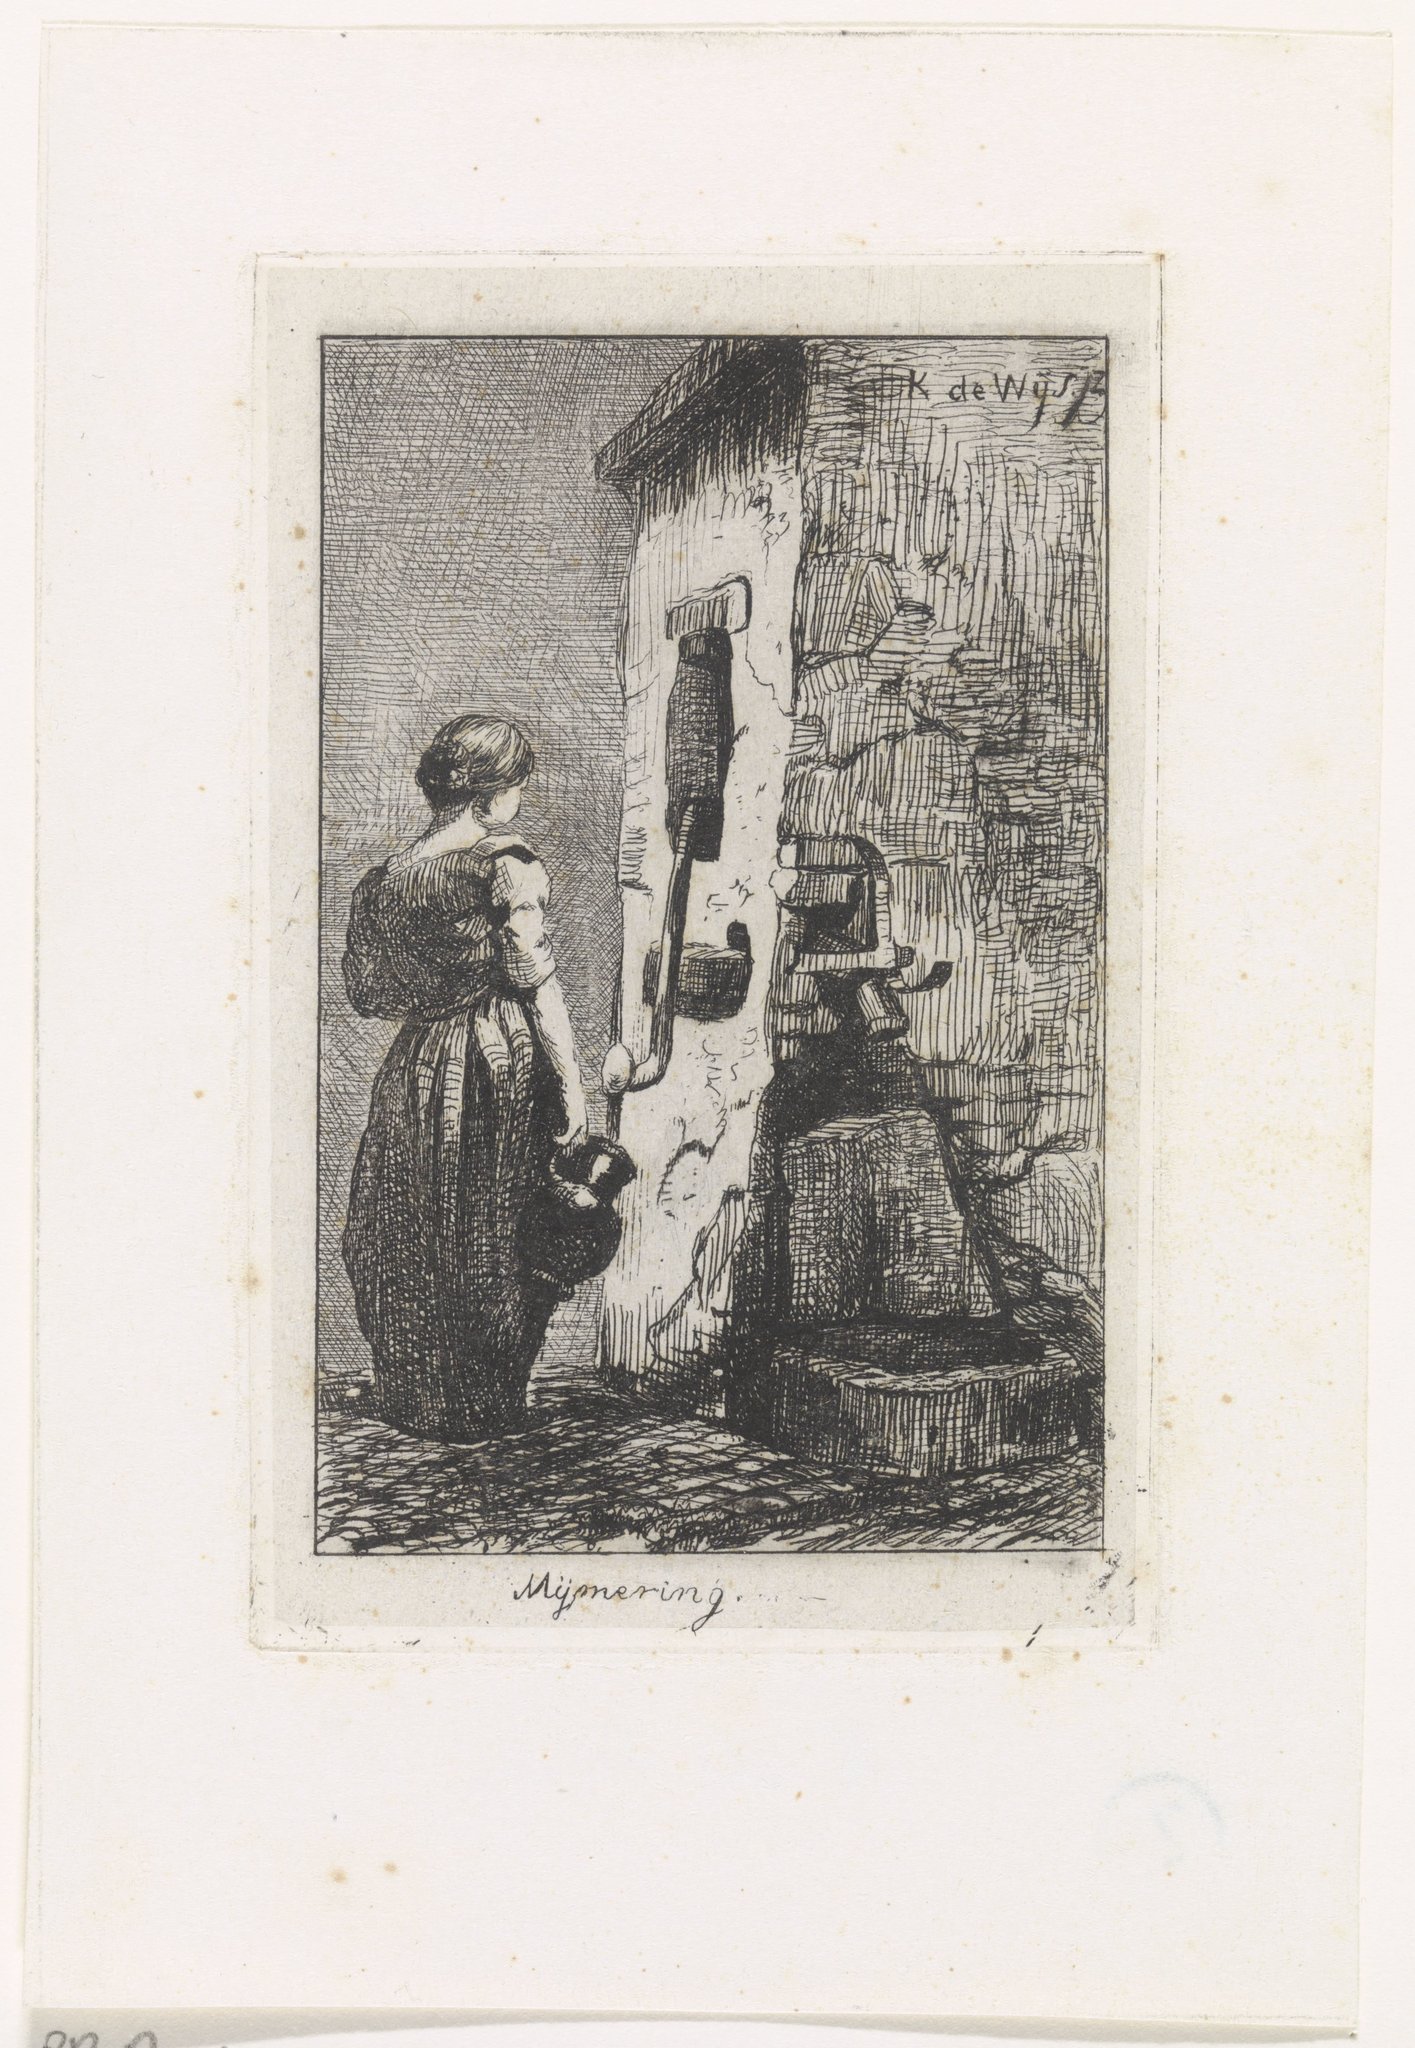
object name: print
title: Mijmering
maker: kornelis jzn de wijs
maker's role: print maker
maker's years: 1832-1896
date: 1842-1896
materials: paper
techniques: etching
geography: netherlands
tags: container of ceramics: jar, jug, pot, vase, utilitarian, public pump or water fountain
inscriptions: collector's mark: Lugt 138, collector's mark: Lugt 2228, collector's mark: Lugt 2760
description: Een jonge vrouw staat in gedachten verzonken met een kruik in de hand bij een waterpomp.